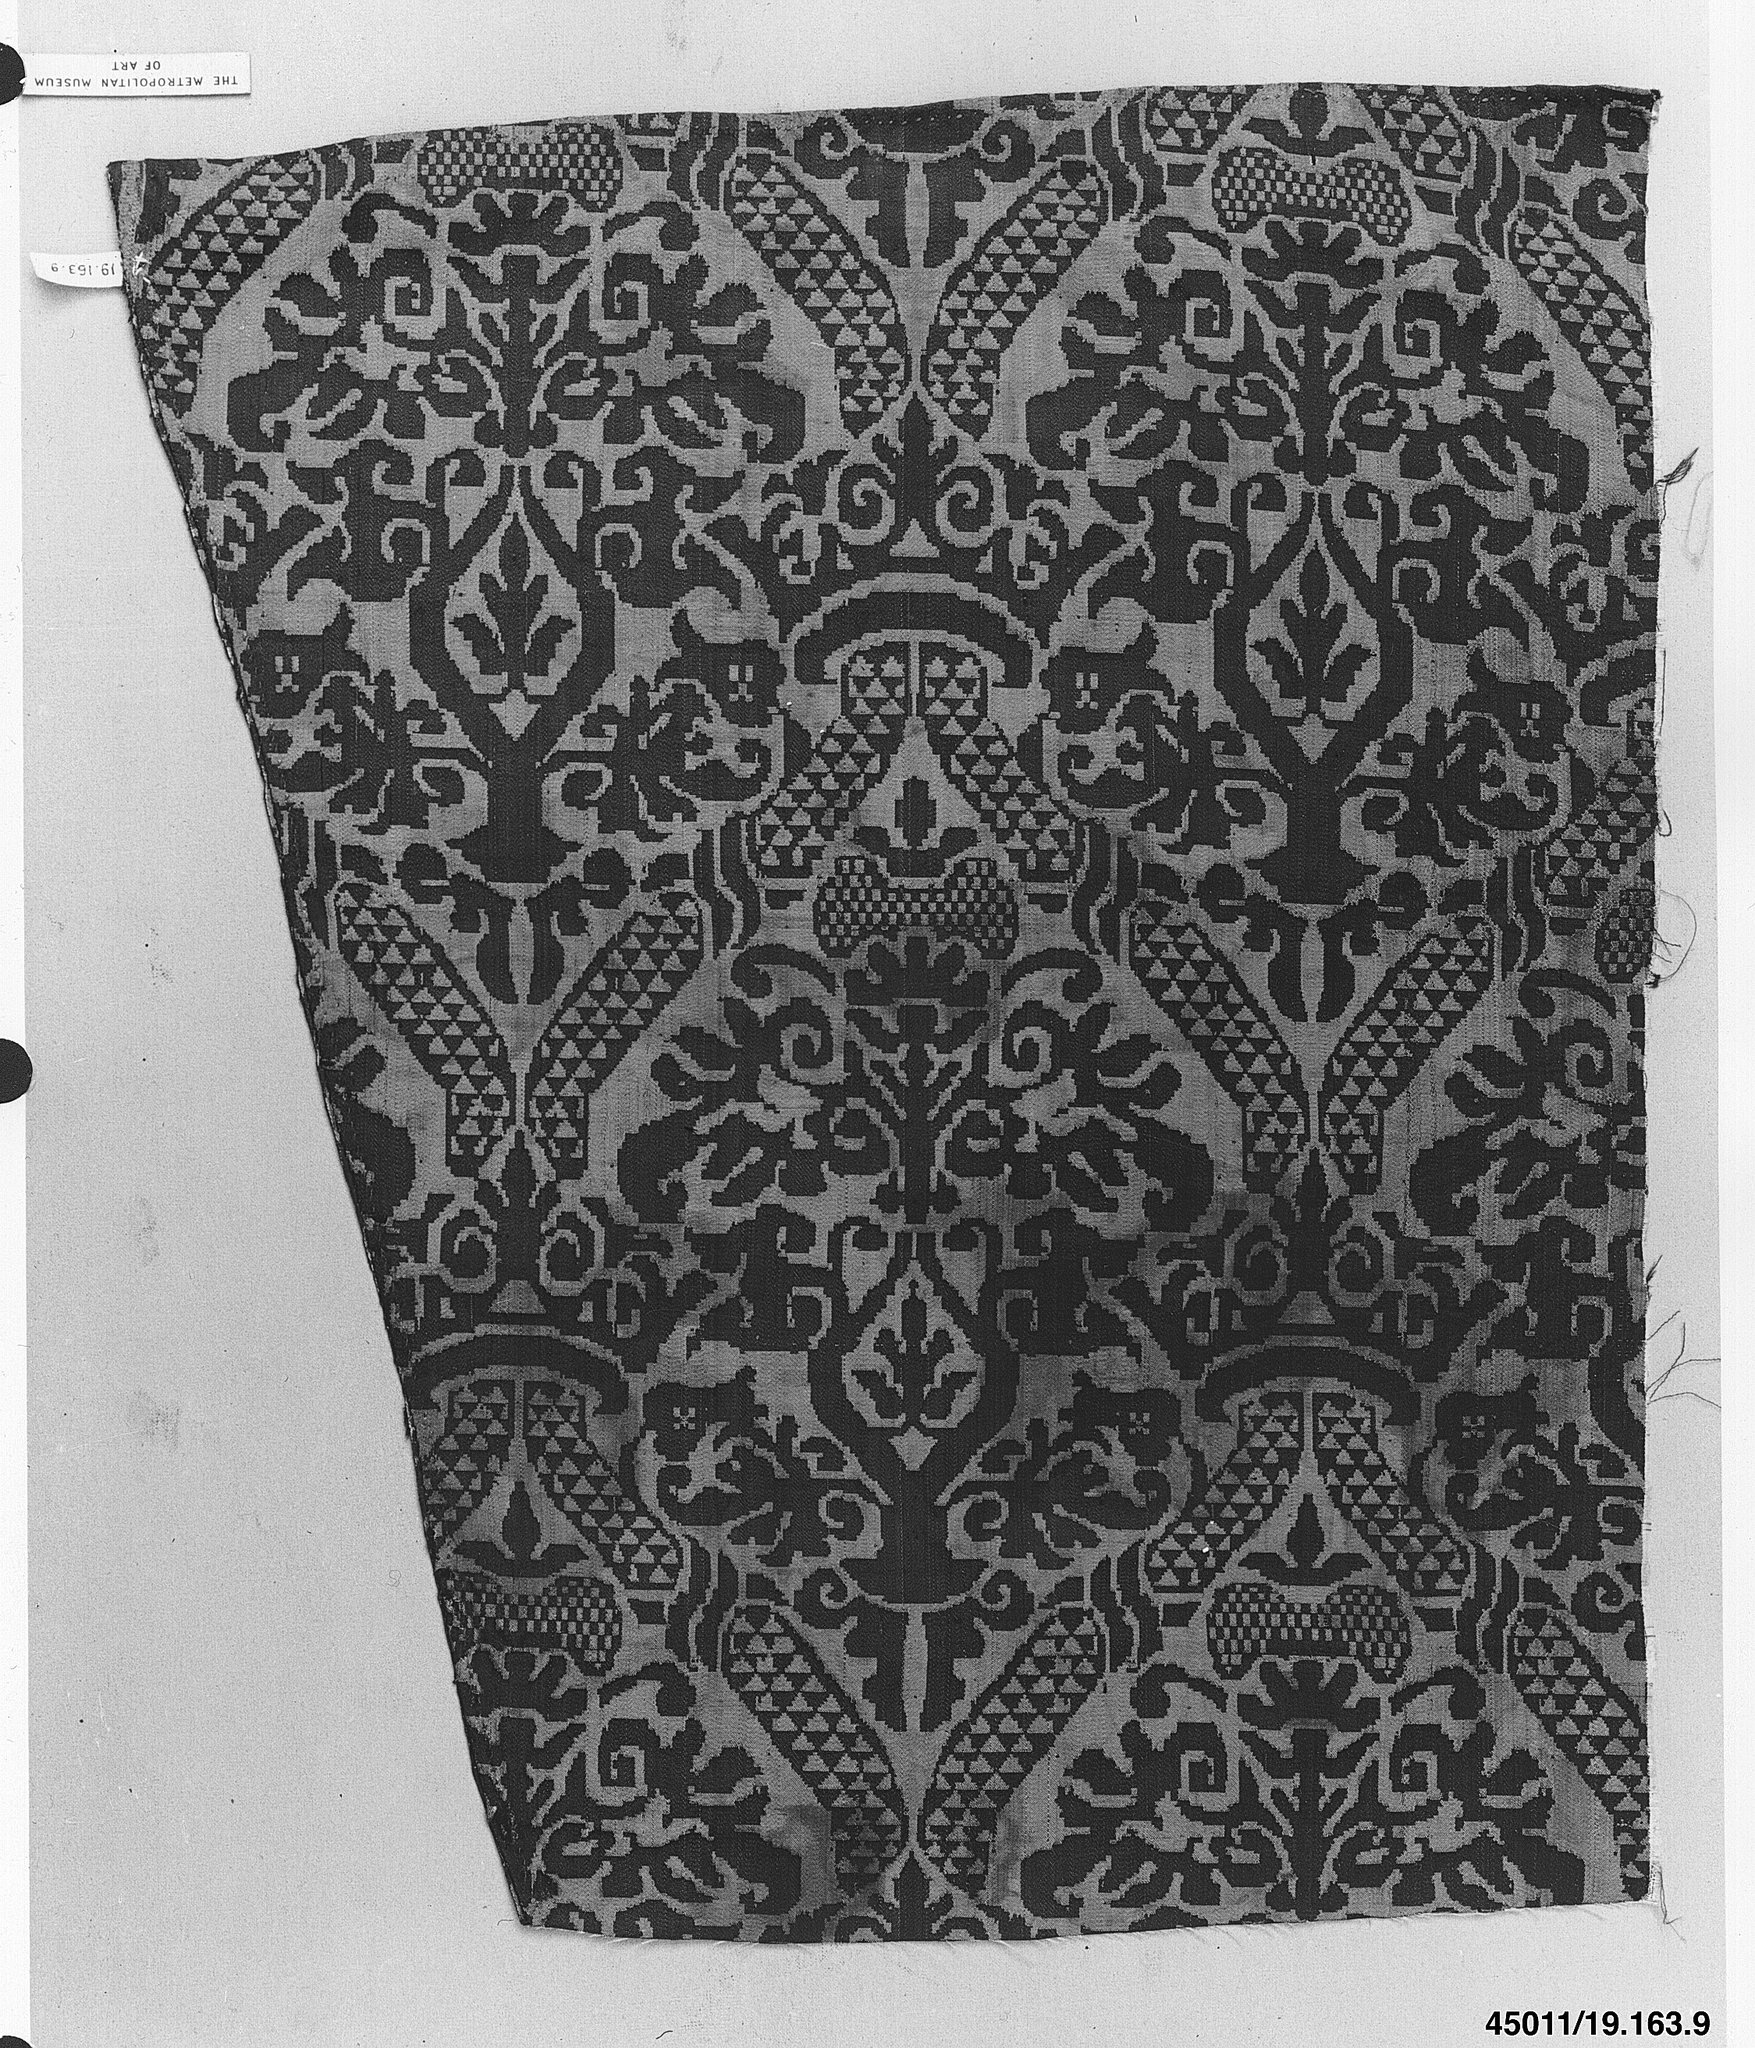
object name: piece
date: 1501-1600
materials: silk